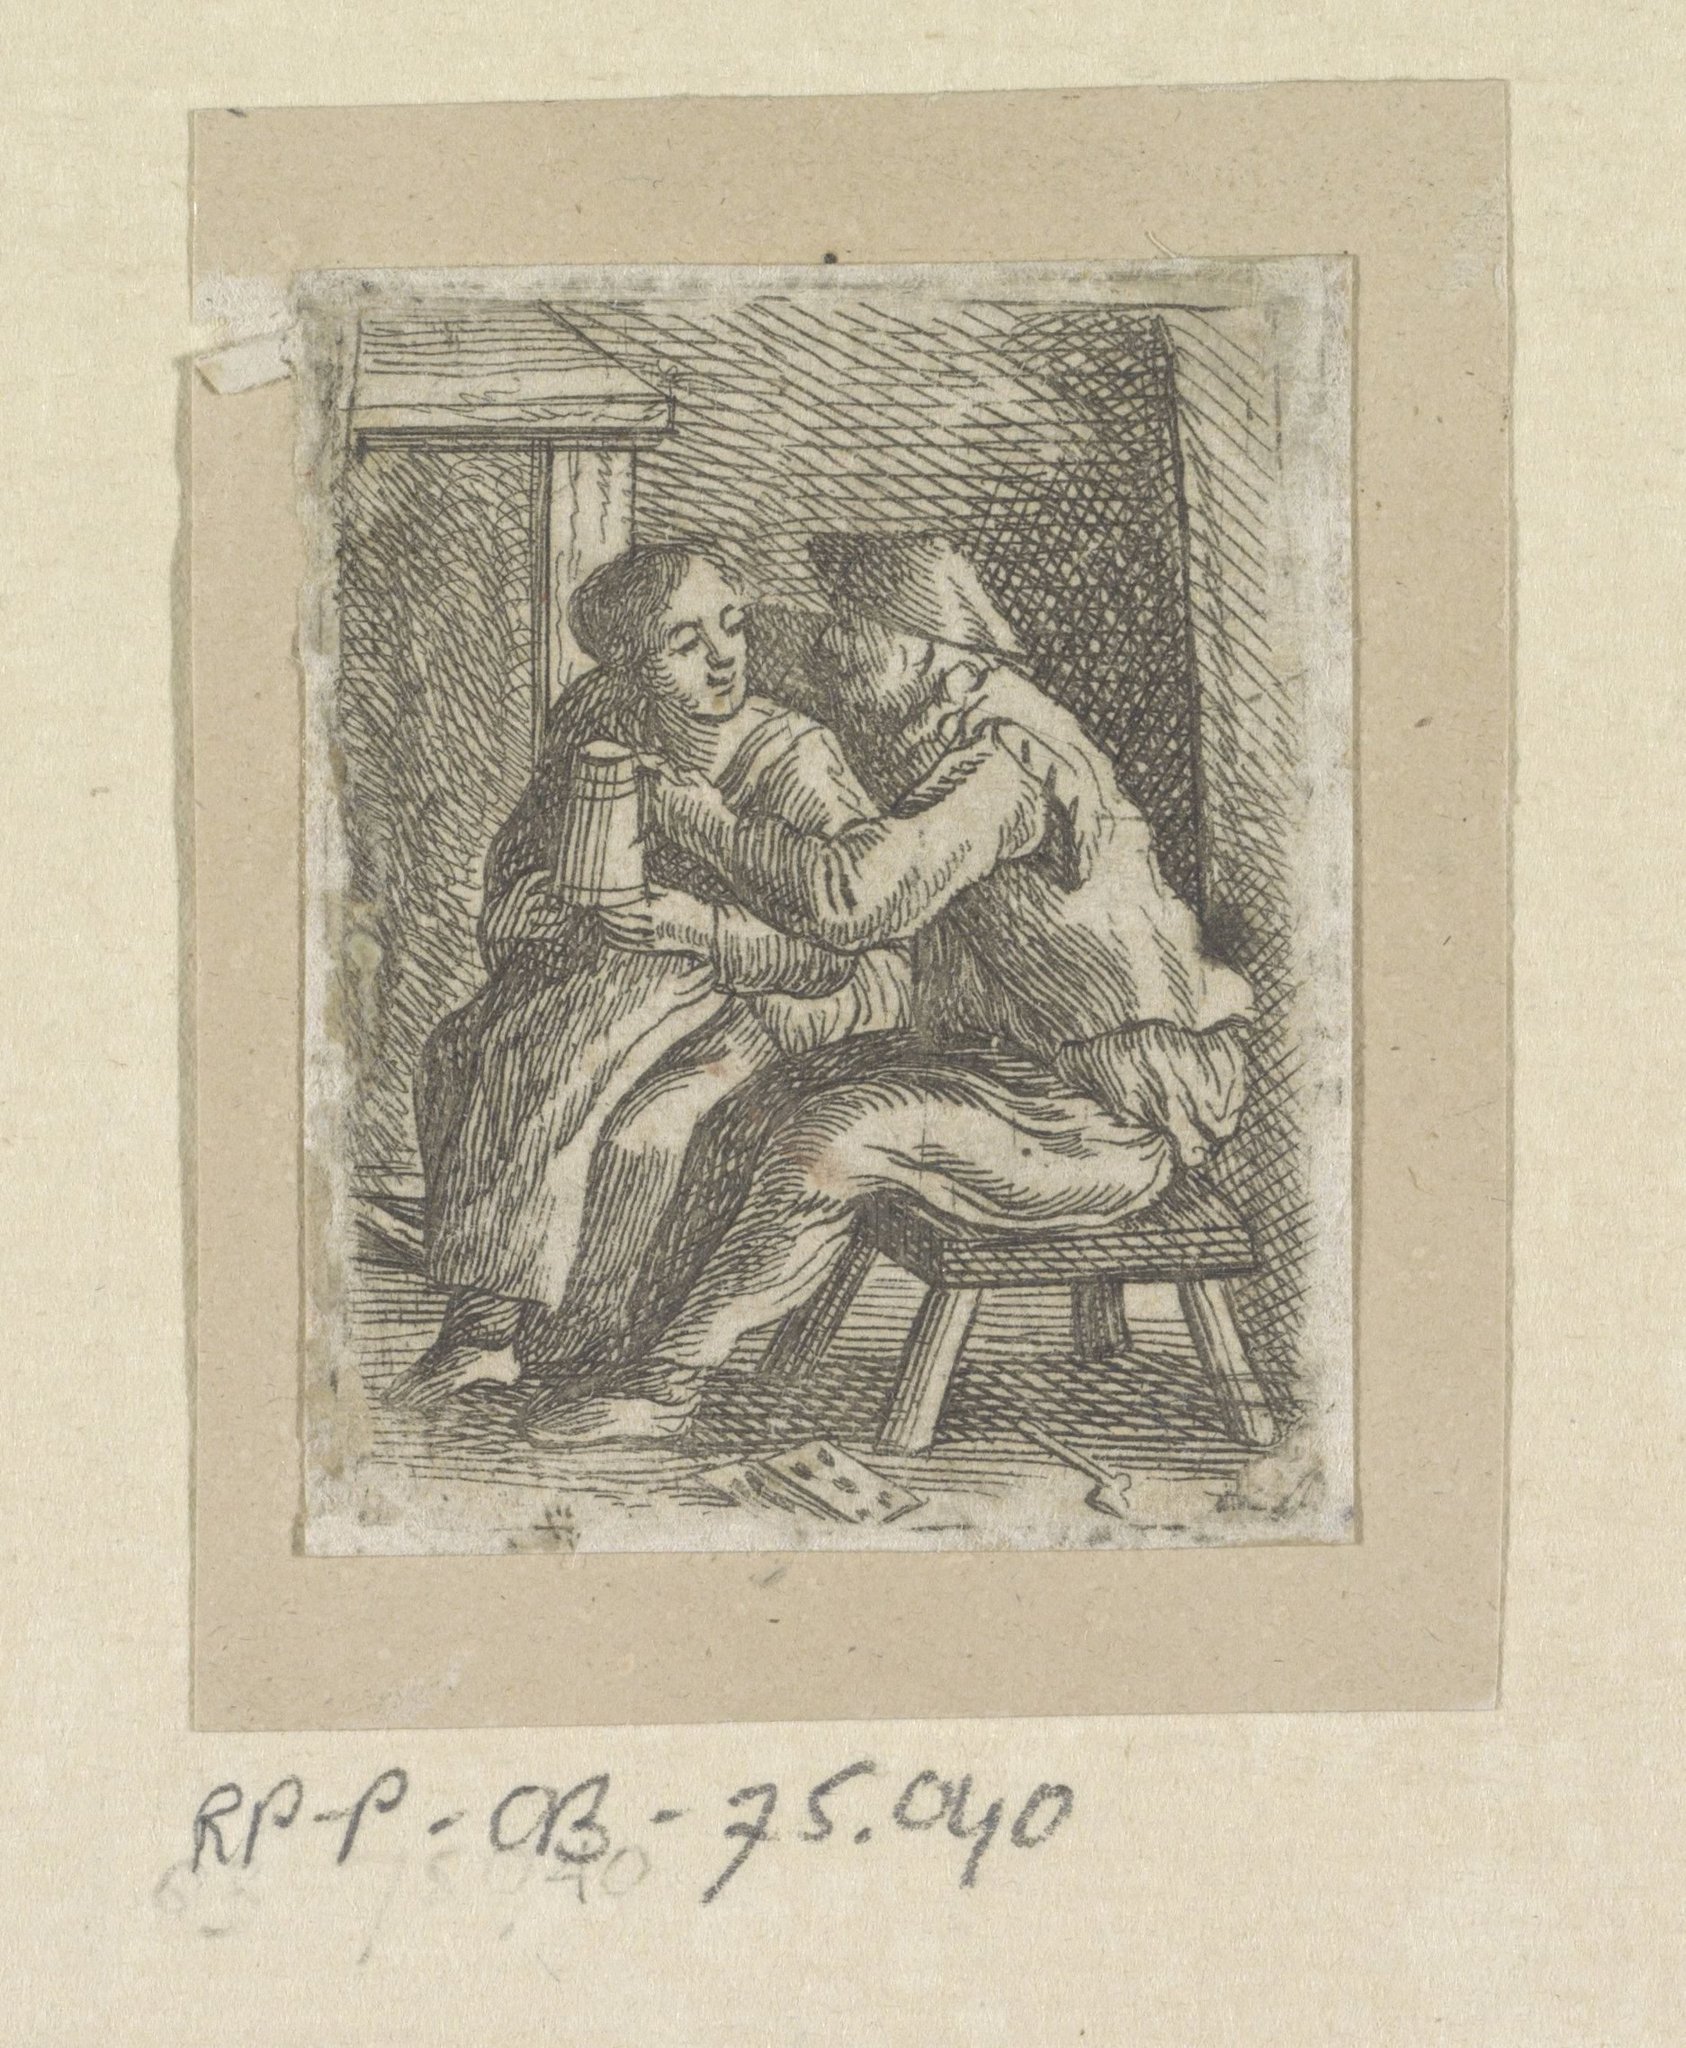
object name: print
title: Man omhelst een vrouw in een herberg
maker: Anonymous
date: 1600-1700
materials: paper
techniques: engraving, etching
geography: netherlands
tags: inn, coffee-house, public house, etc., couple of lovers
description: Een man omhelst een vrouw in een herberg en geeft haar een bierpul. Op de grond liggen speelkaarten en een pijp.